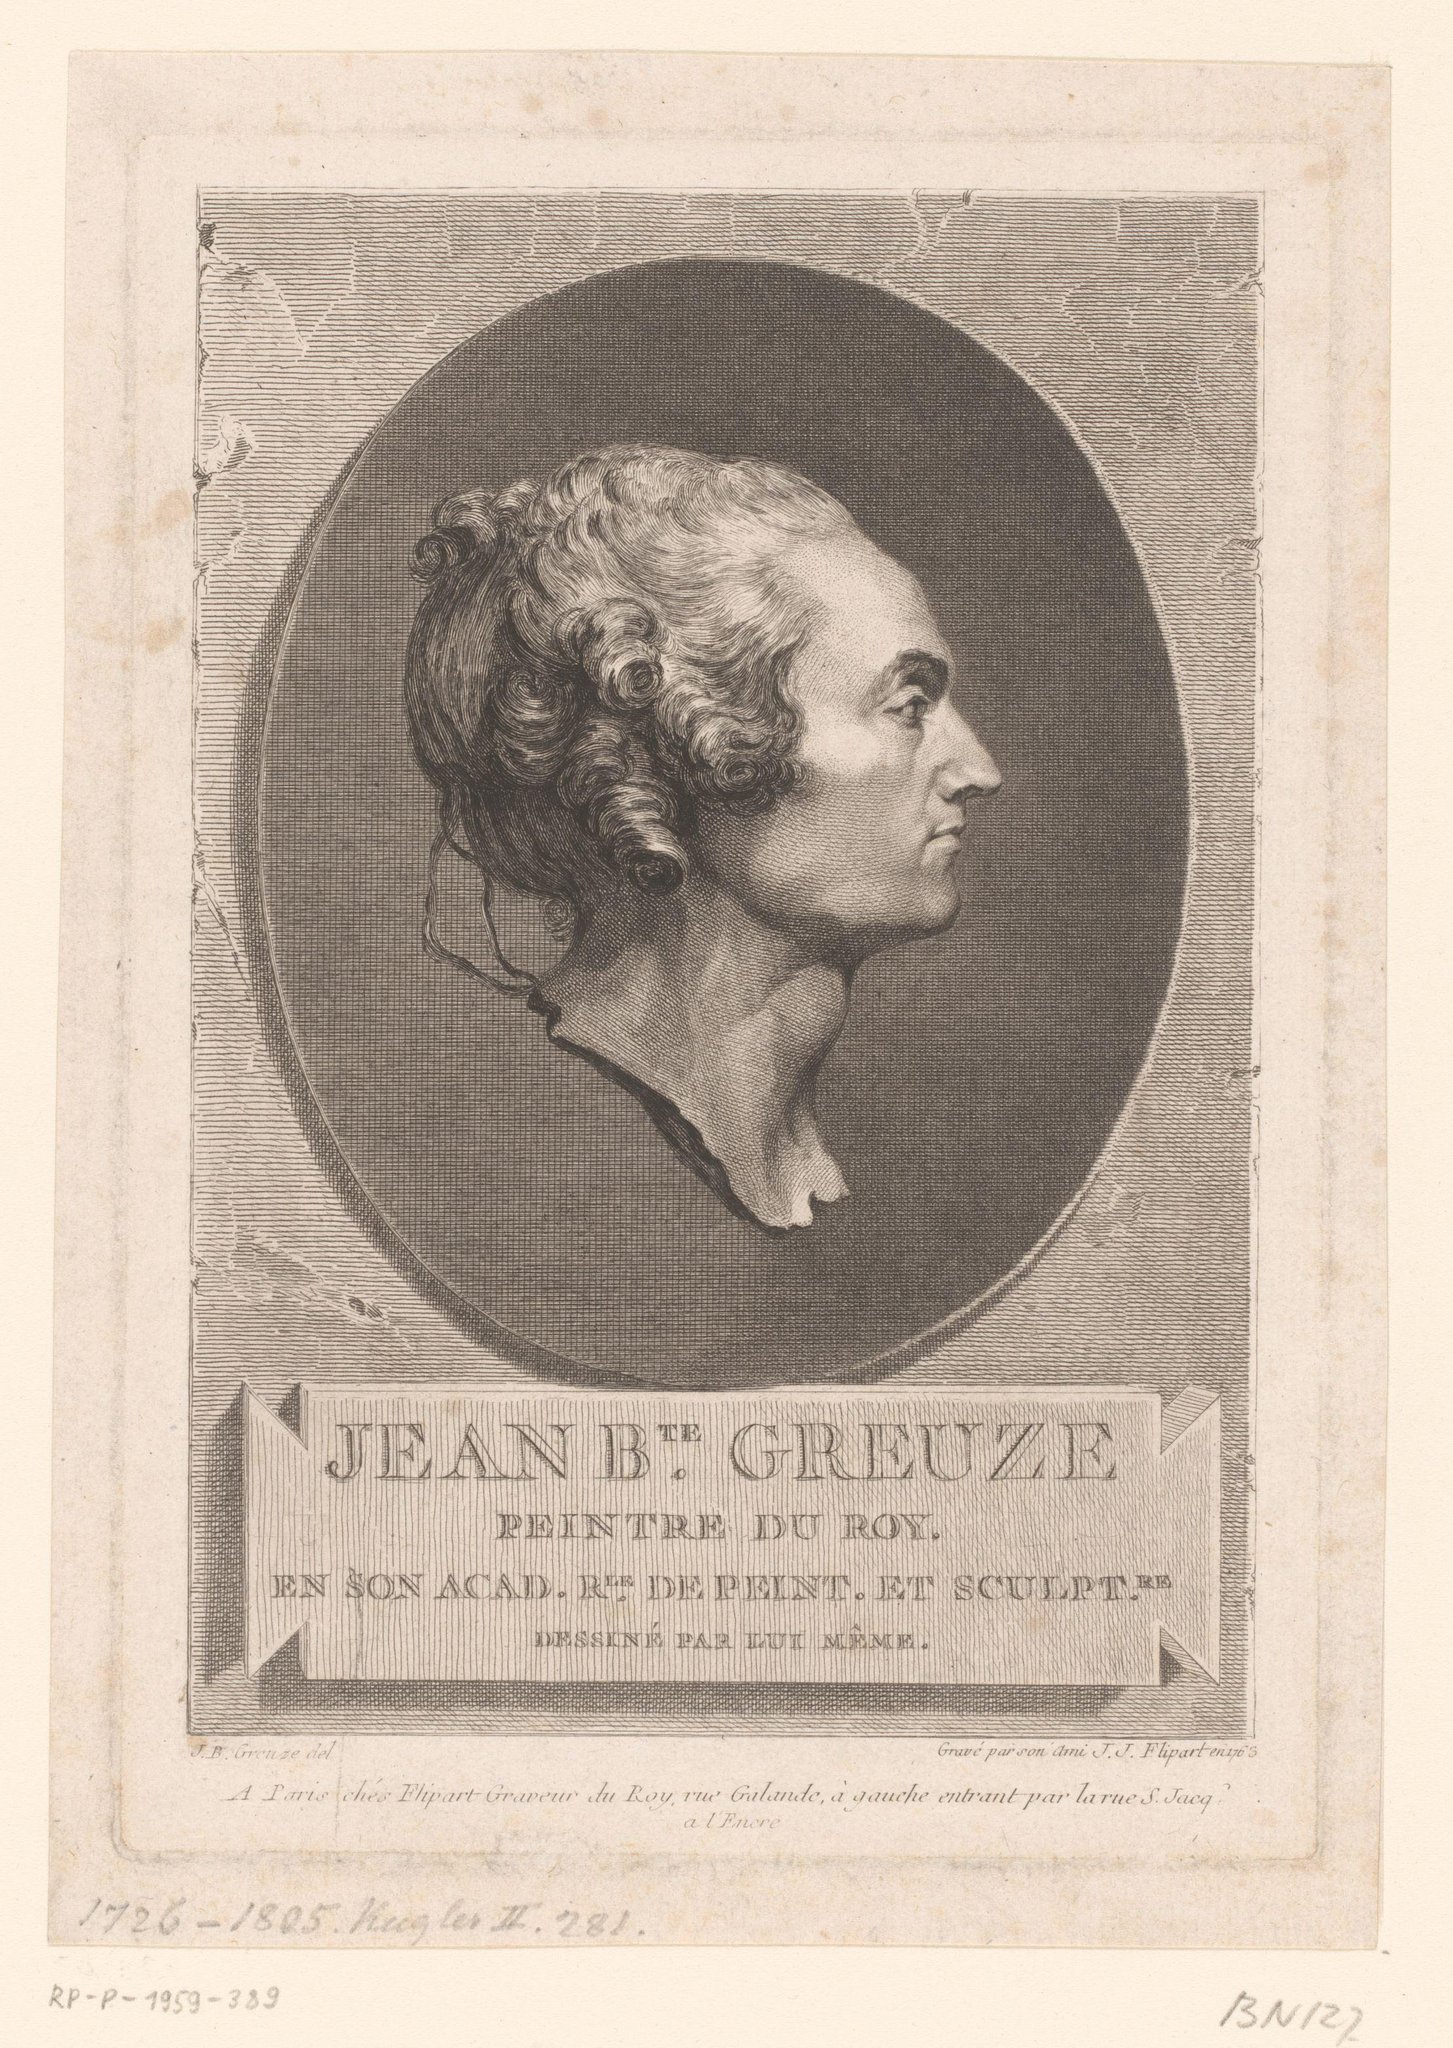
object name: print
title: Jean Bte. Greuze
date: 1763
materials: paper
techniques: engraving, etching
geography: france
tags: painter, jean-baptiste greuze, historical persons, portrait, self-portrait of painter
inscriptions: collector's mark: Lugt 4347, collector's mark: Lugt 2760, collector's mark: Lugt 2228